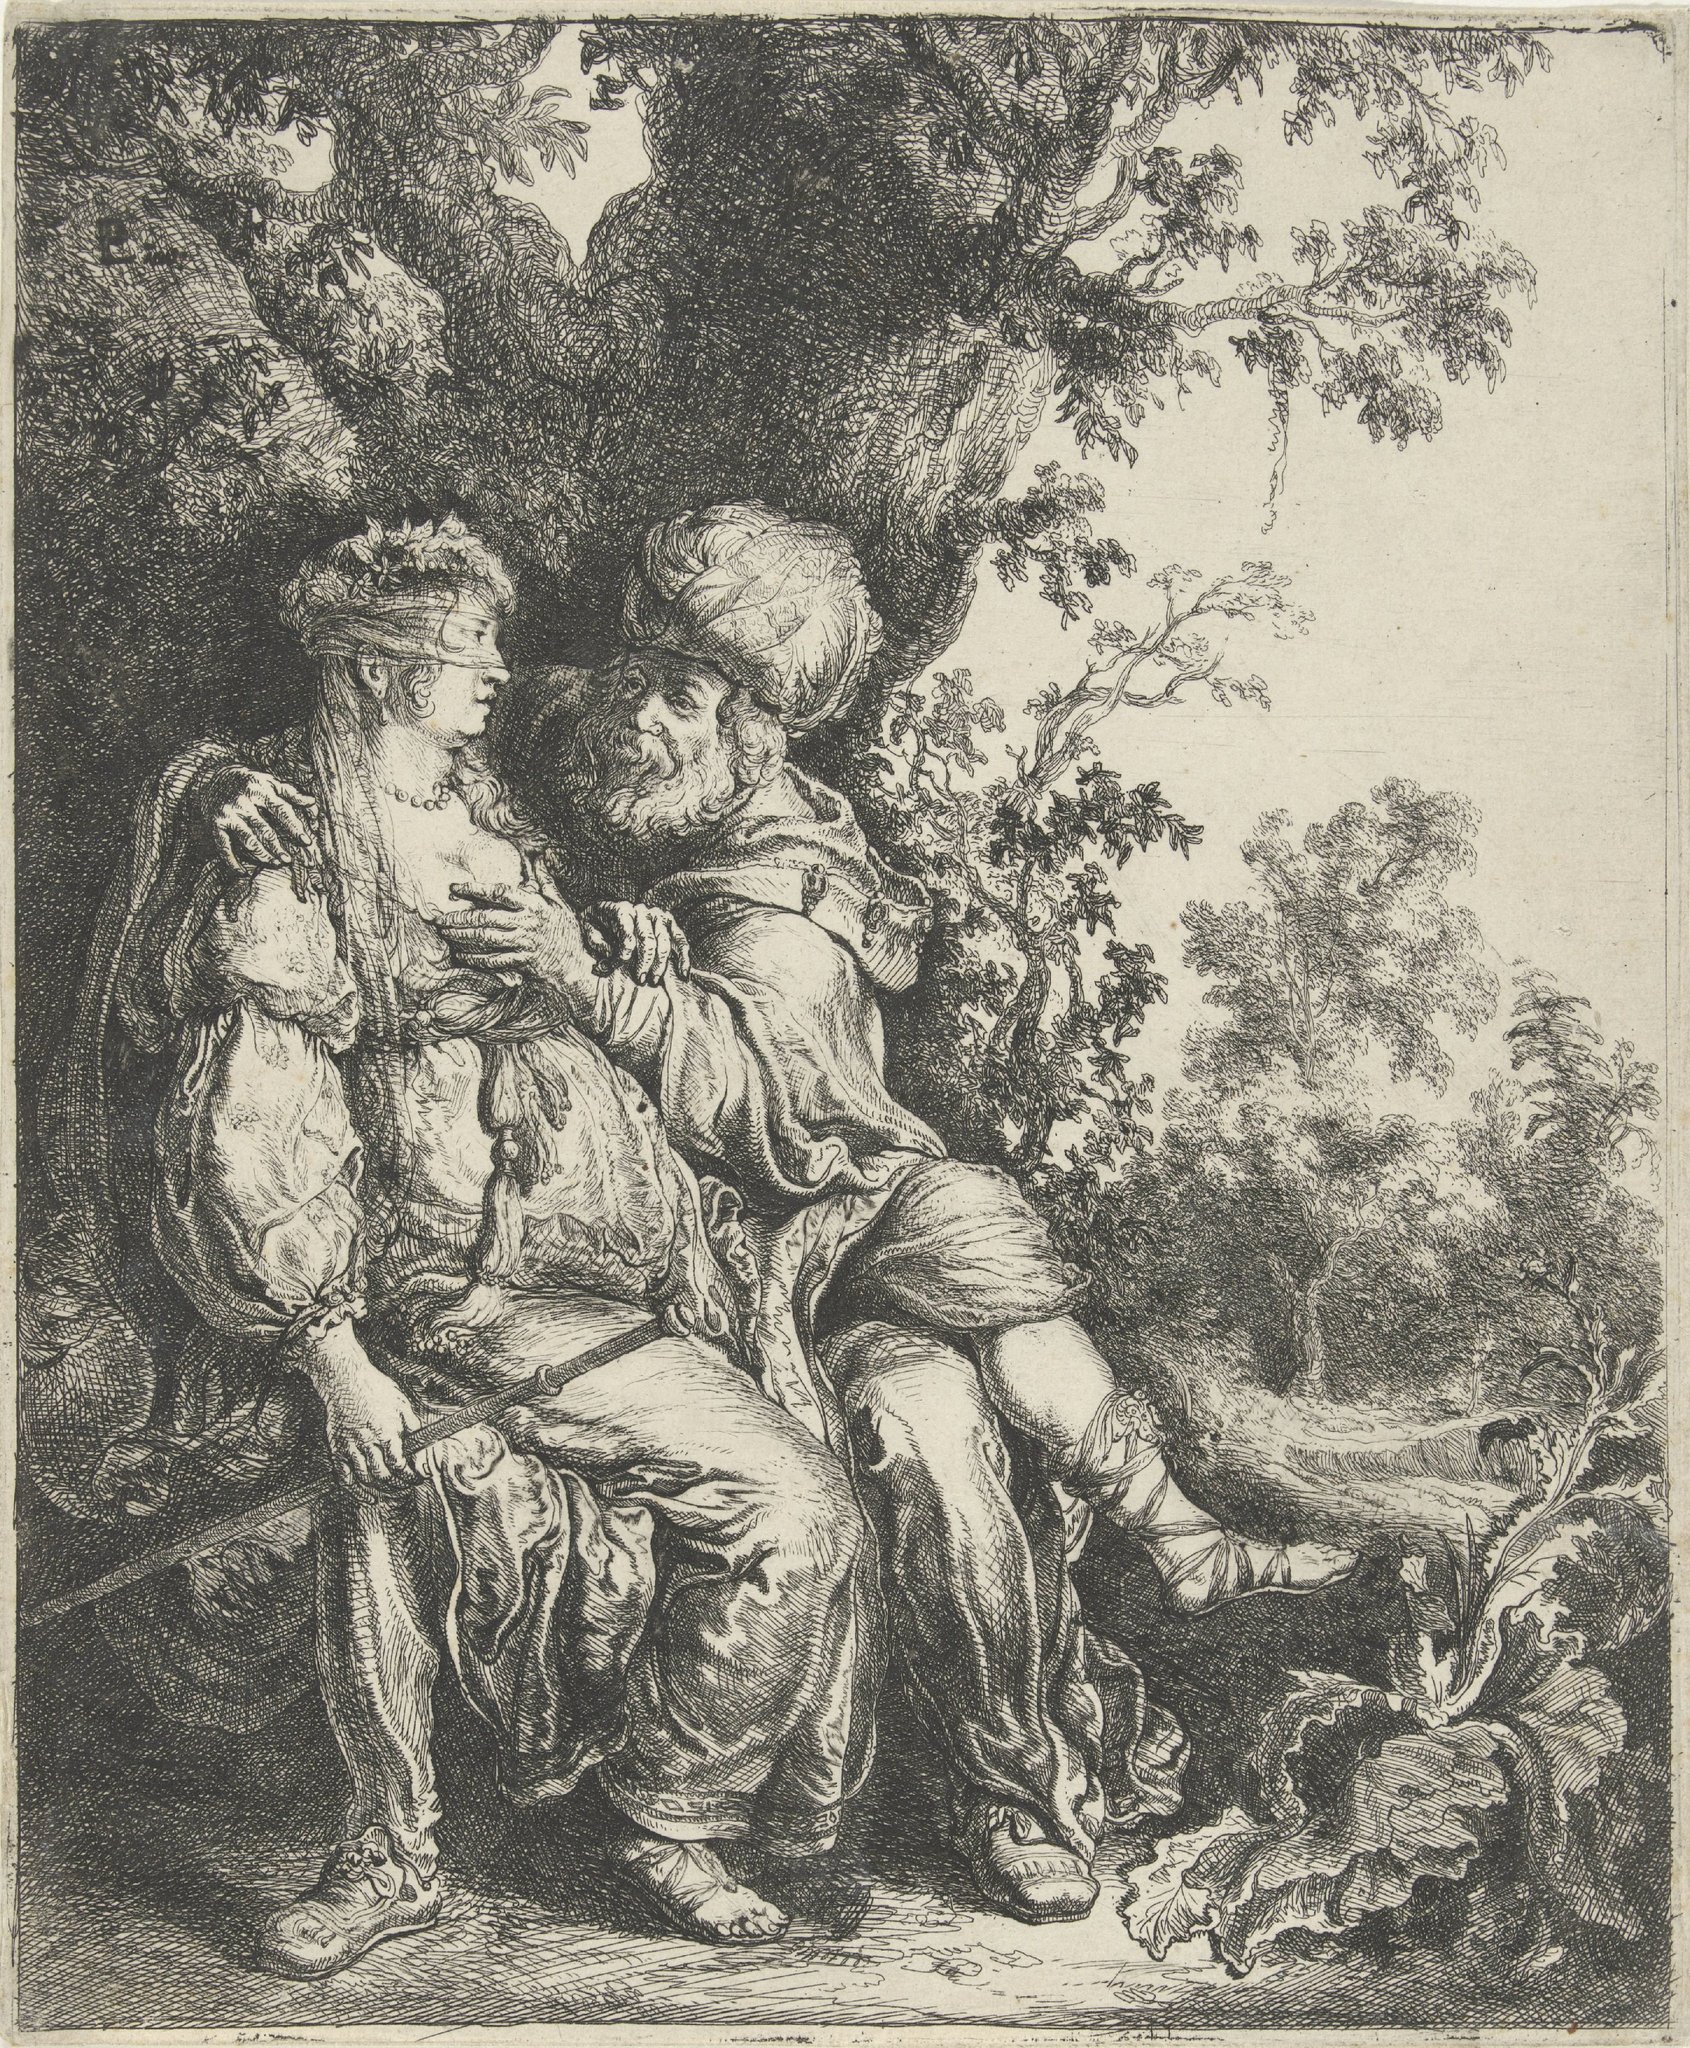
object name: print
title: Juda en Tamar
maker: jan van noordt (1623-1676)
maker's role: draughtsman, painter, print maker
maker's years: 1623-1676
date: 1634-1676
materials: paper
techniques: etching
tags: judah's love-affair with tamar; he gives her his signet(-ring), bracelets and staff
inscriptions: collector's mark: Lugt 240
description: Onder een boom zit Tamar op schoot van haar schoonvader Juda. Tamar is vermomd als hoer en draagt een sluier over haar gezicht. In haar hand houdt ze de staf vast die ze samen met een ring, een armband en een geitebokje als onderpand van Juda had gekregen in ruil voor gemeenschap.